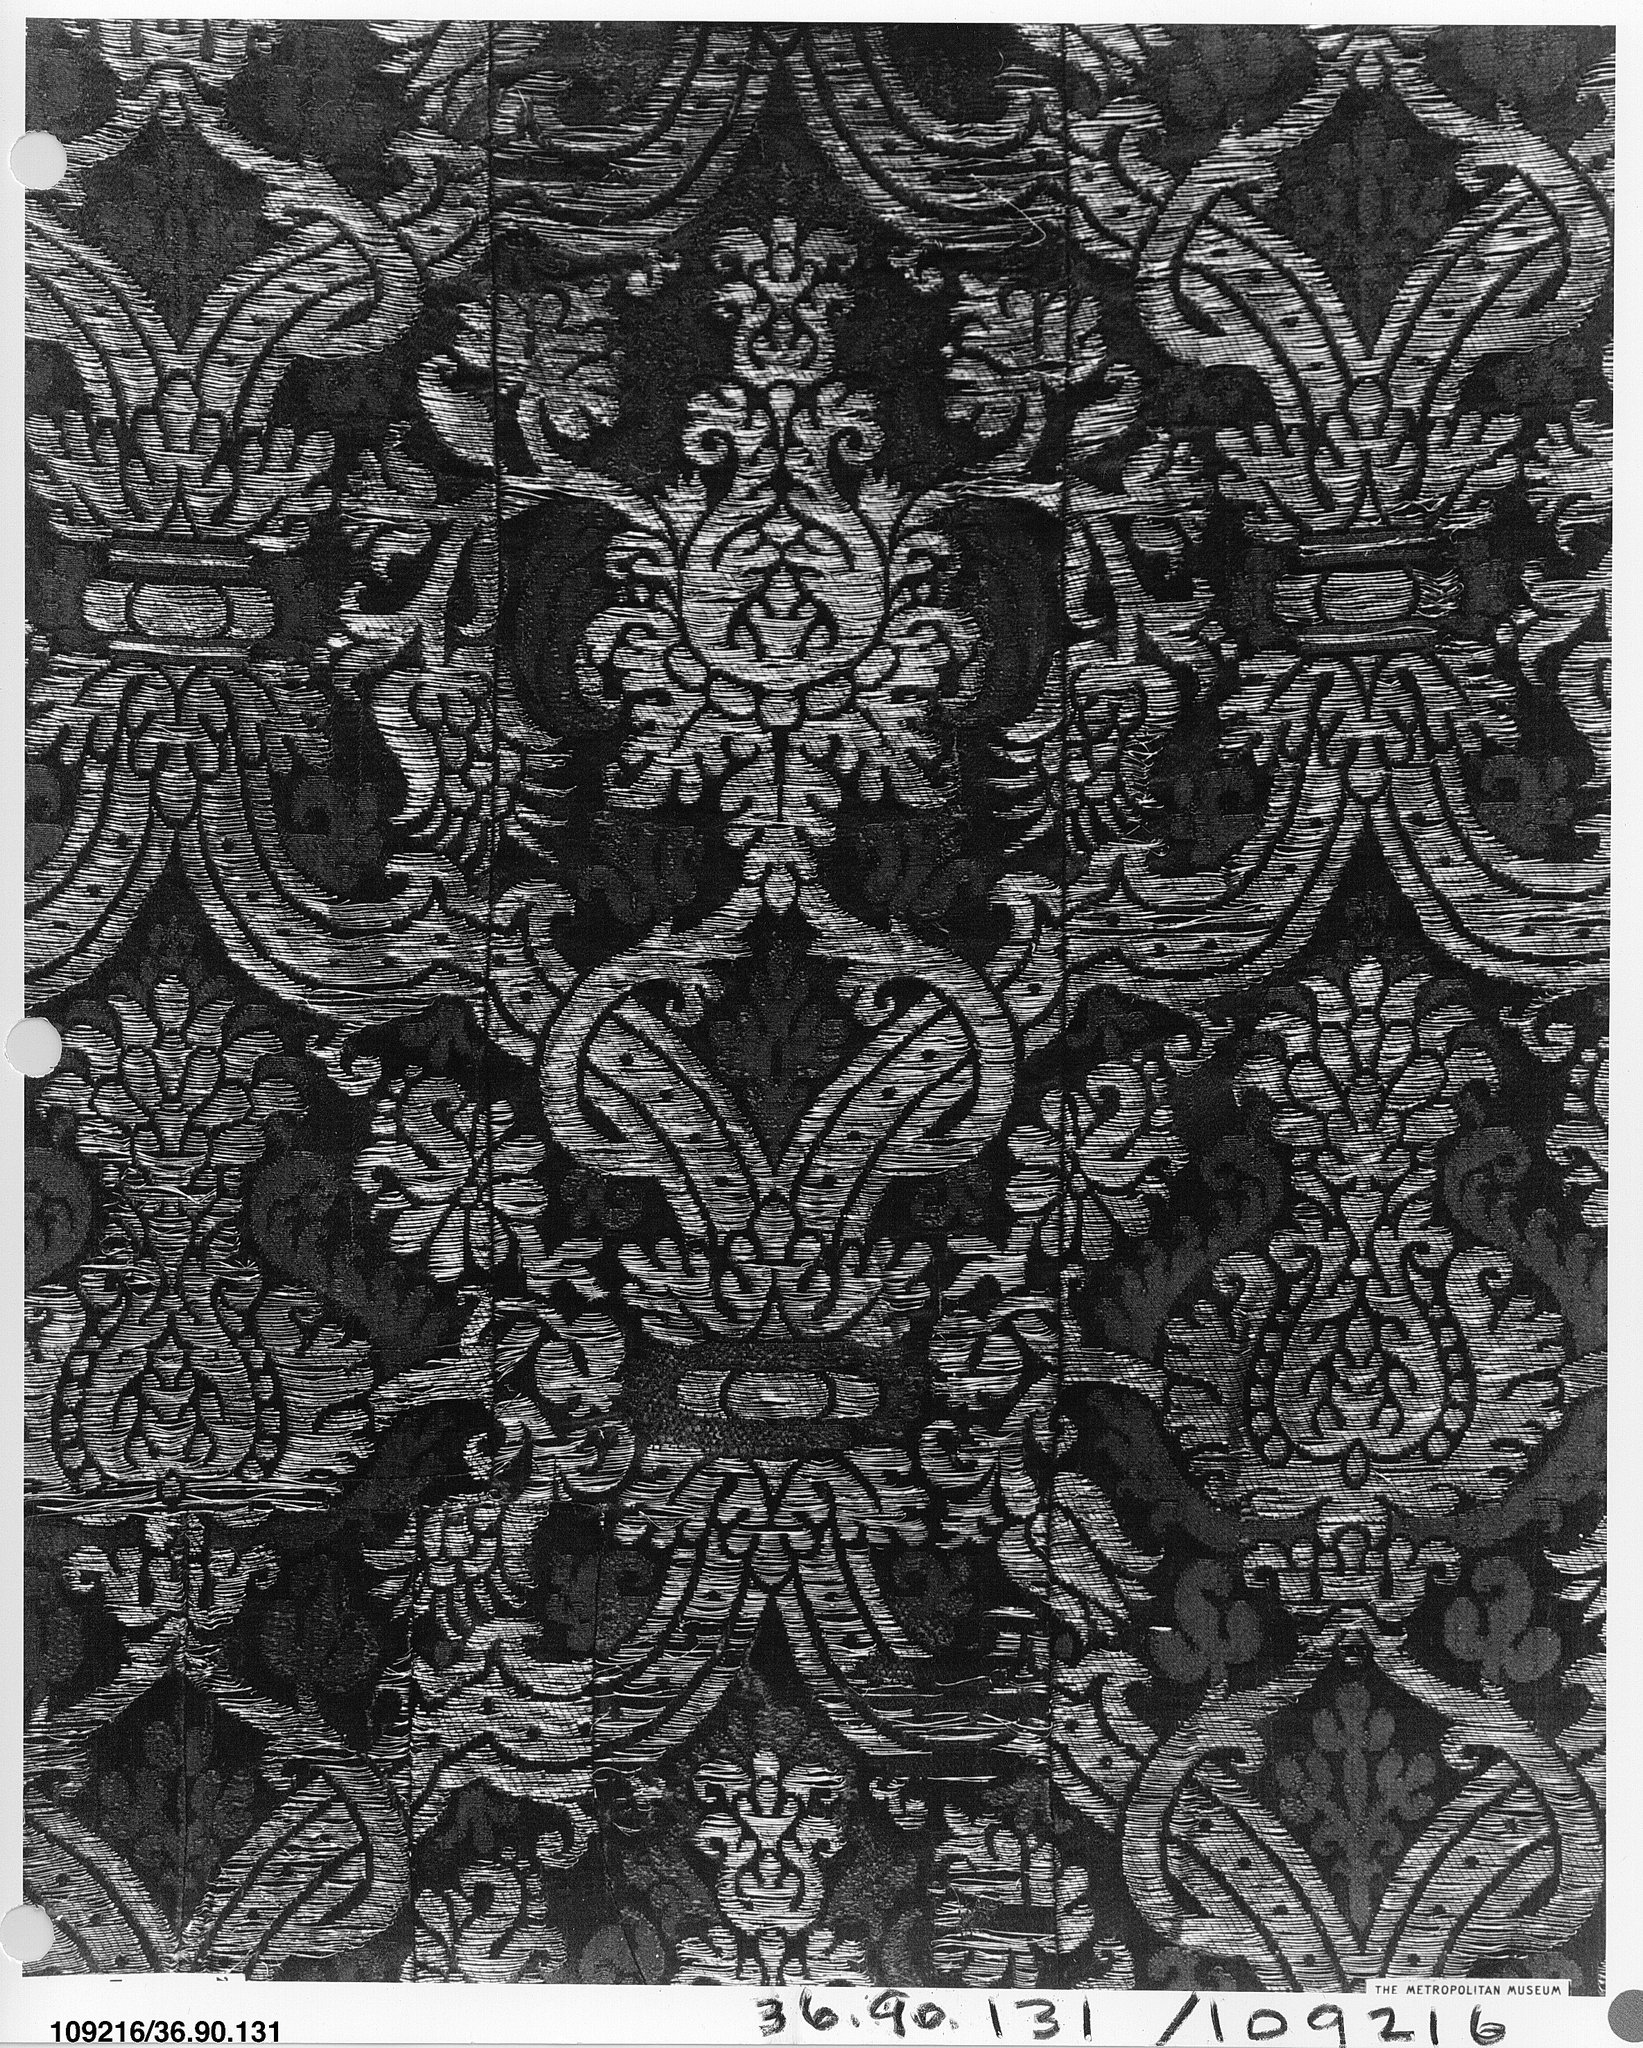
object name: piece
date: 1501-1600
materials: metal thread, silk